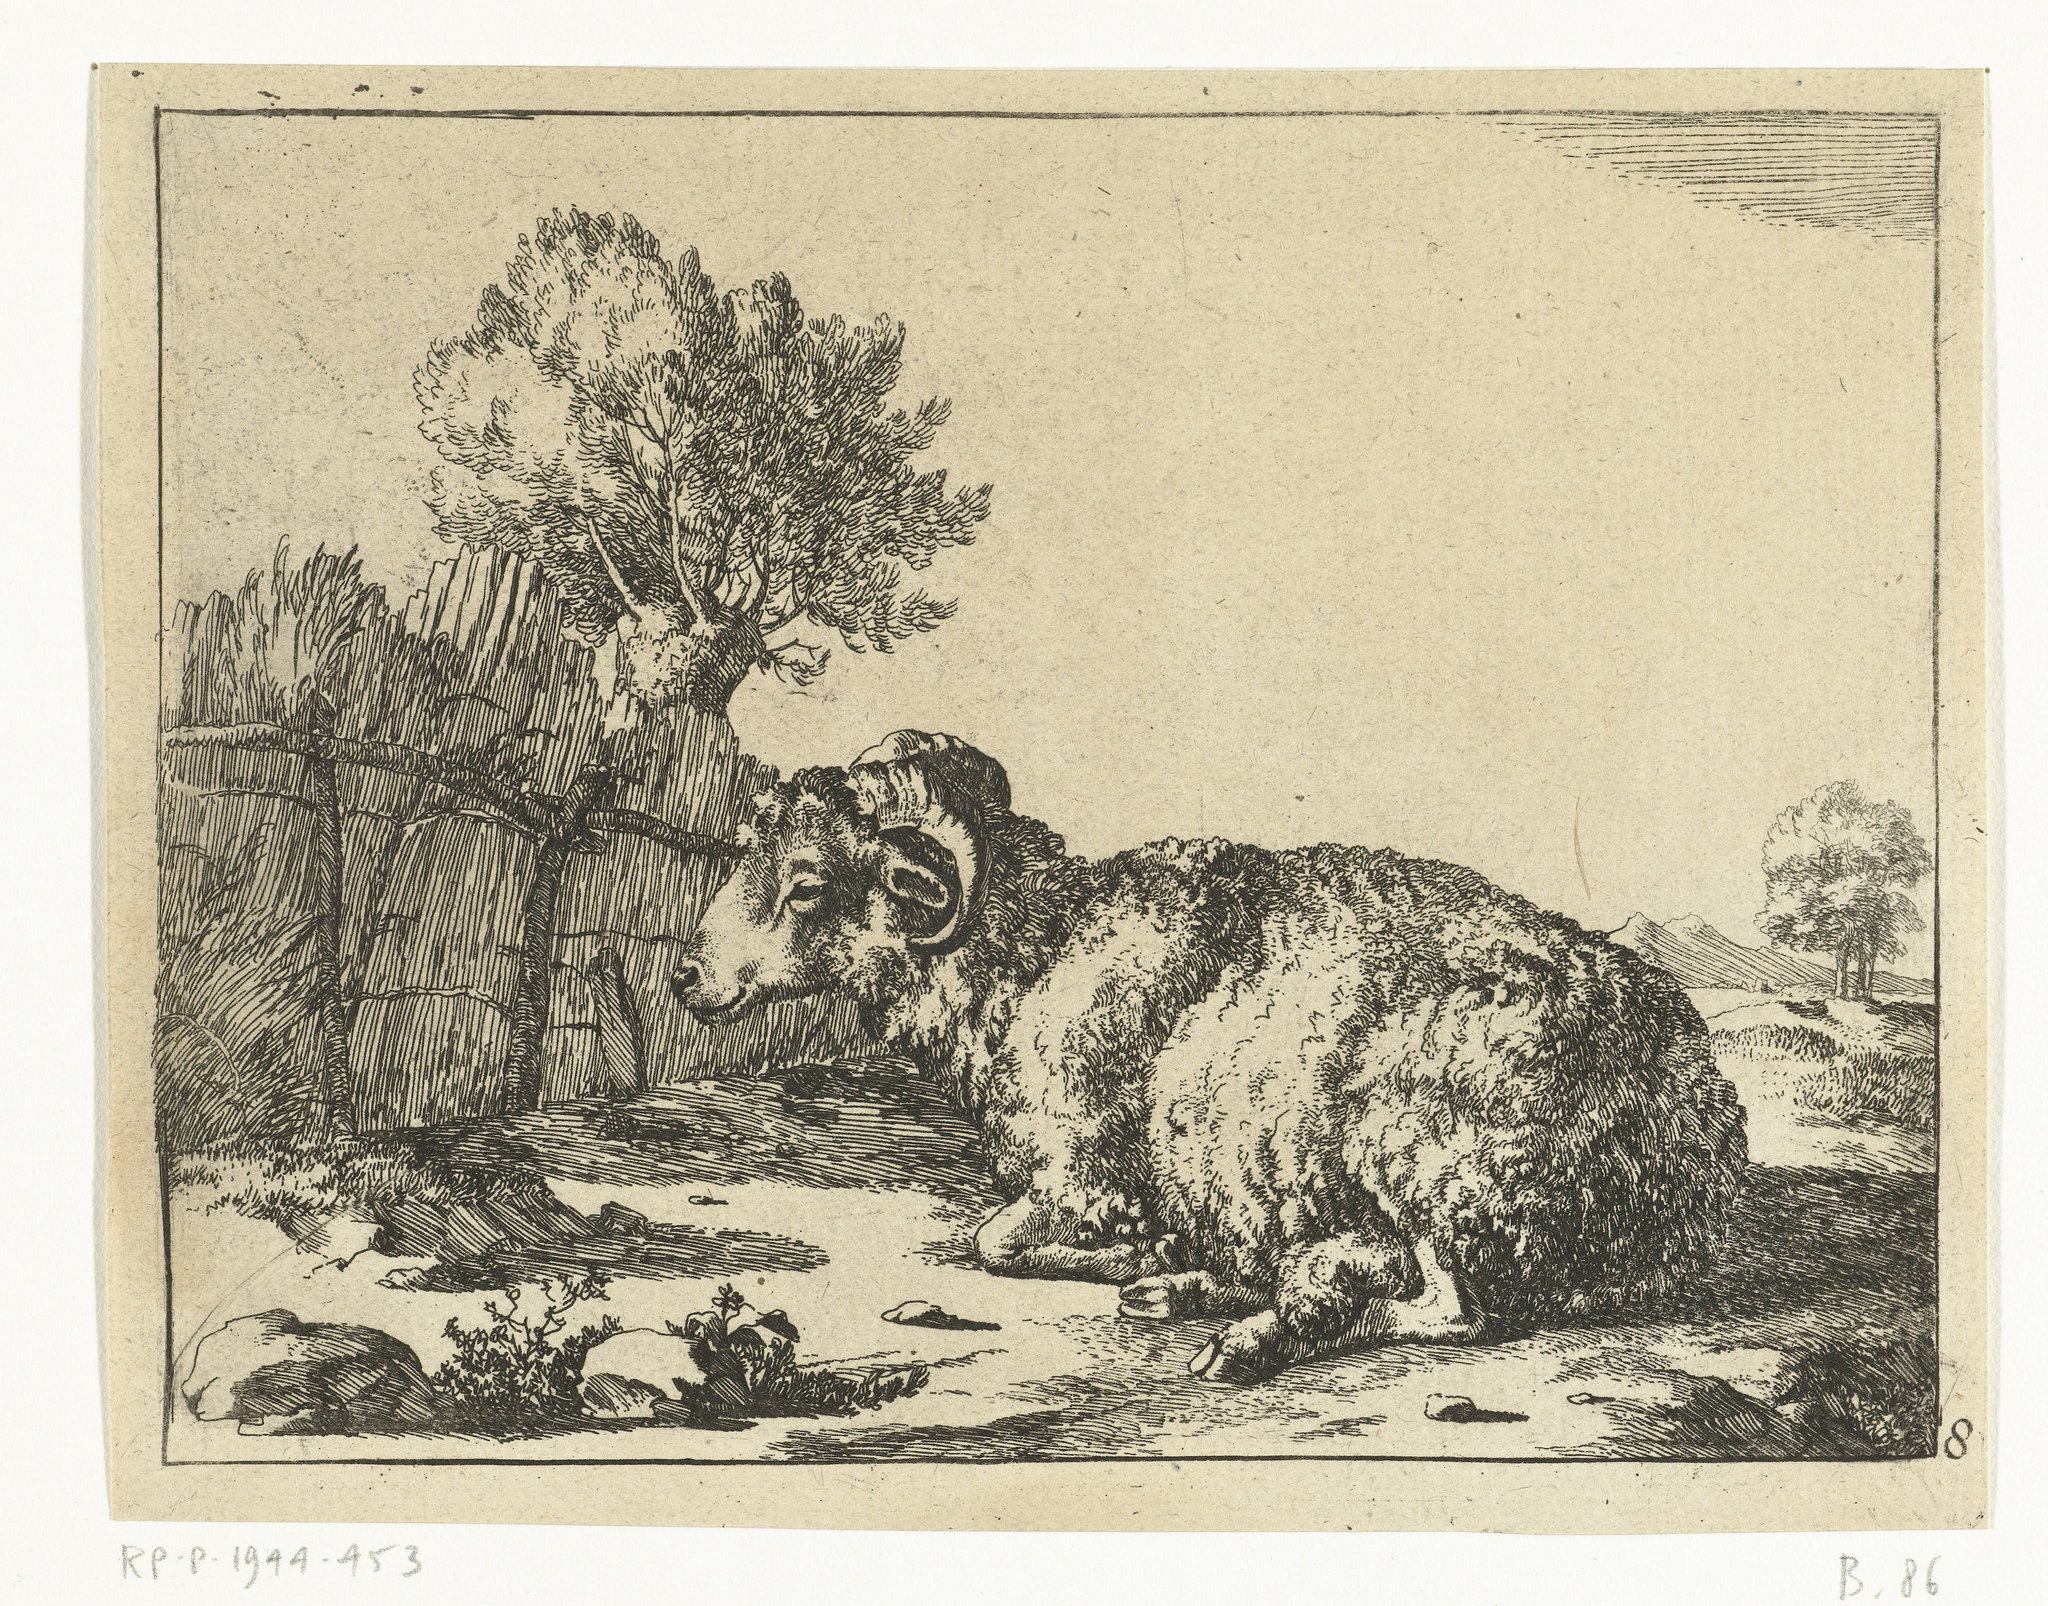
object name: print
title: Schapen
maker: marcus de bye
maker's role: print maker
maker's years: 1639-1688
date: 1664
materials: paper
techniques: etching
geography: the hague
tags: sheep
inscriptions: collector's mark: Lugt 2228